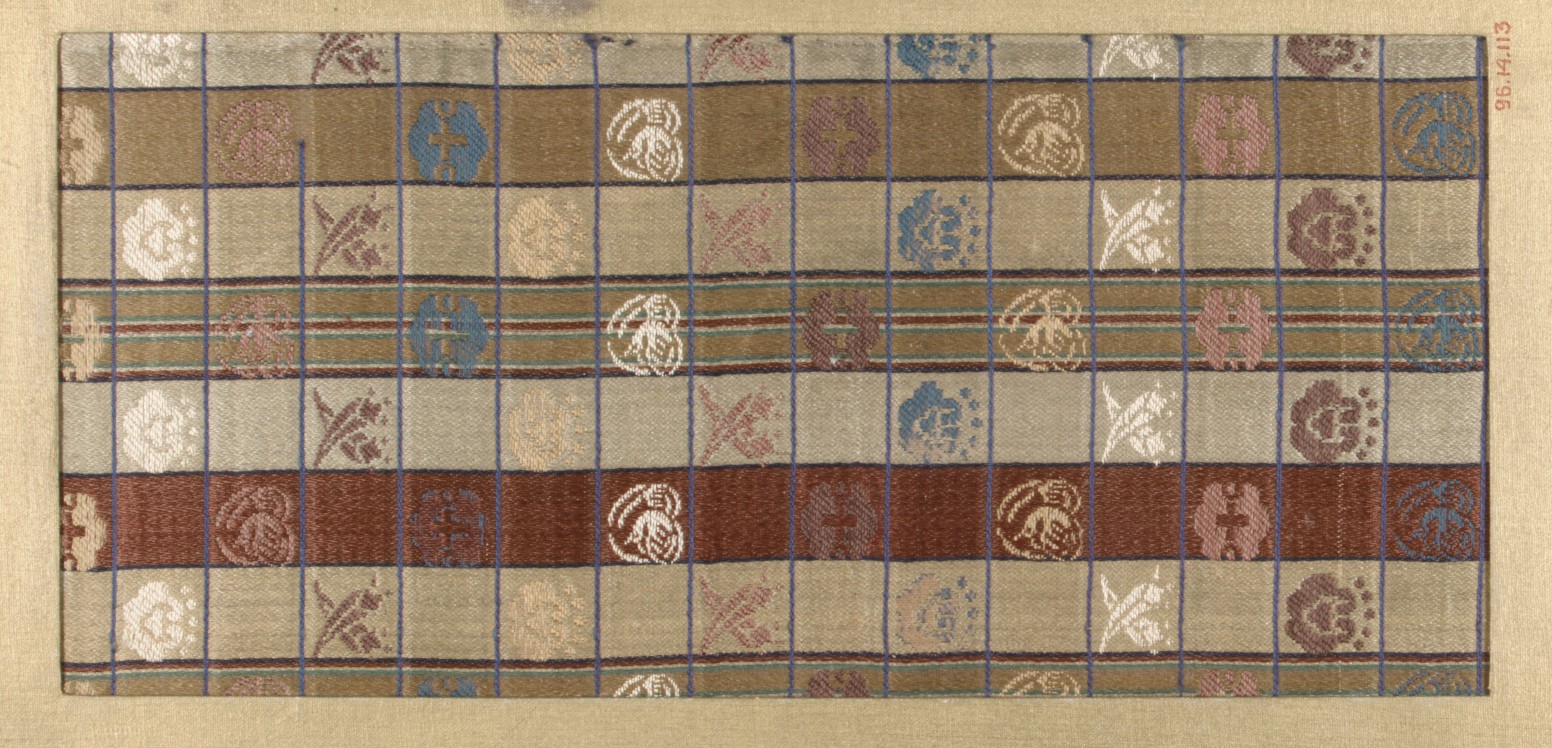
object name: piece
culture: japanese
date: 1701-1900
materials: silk